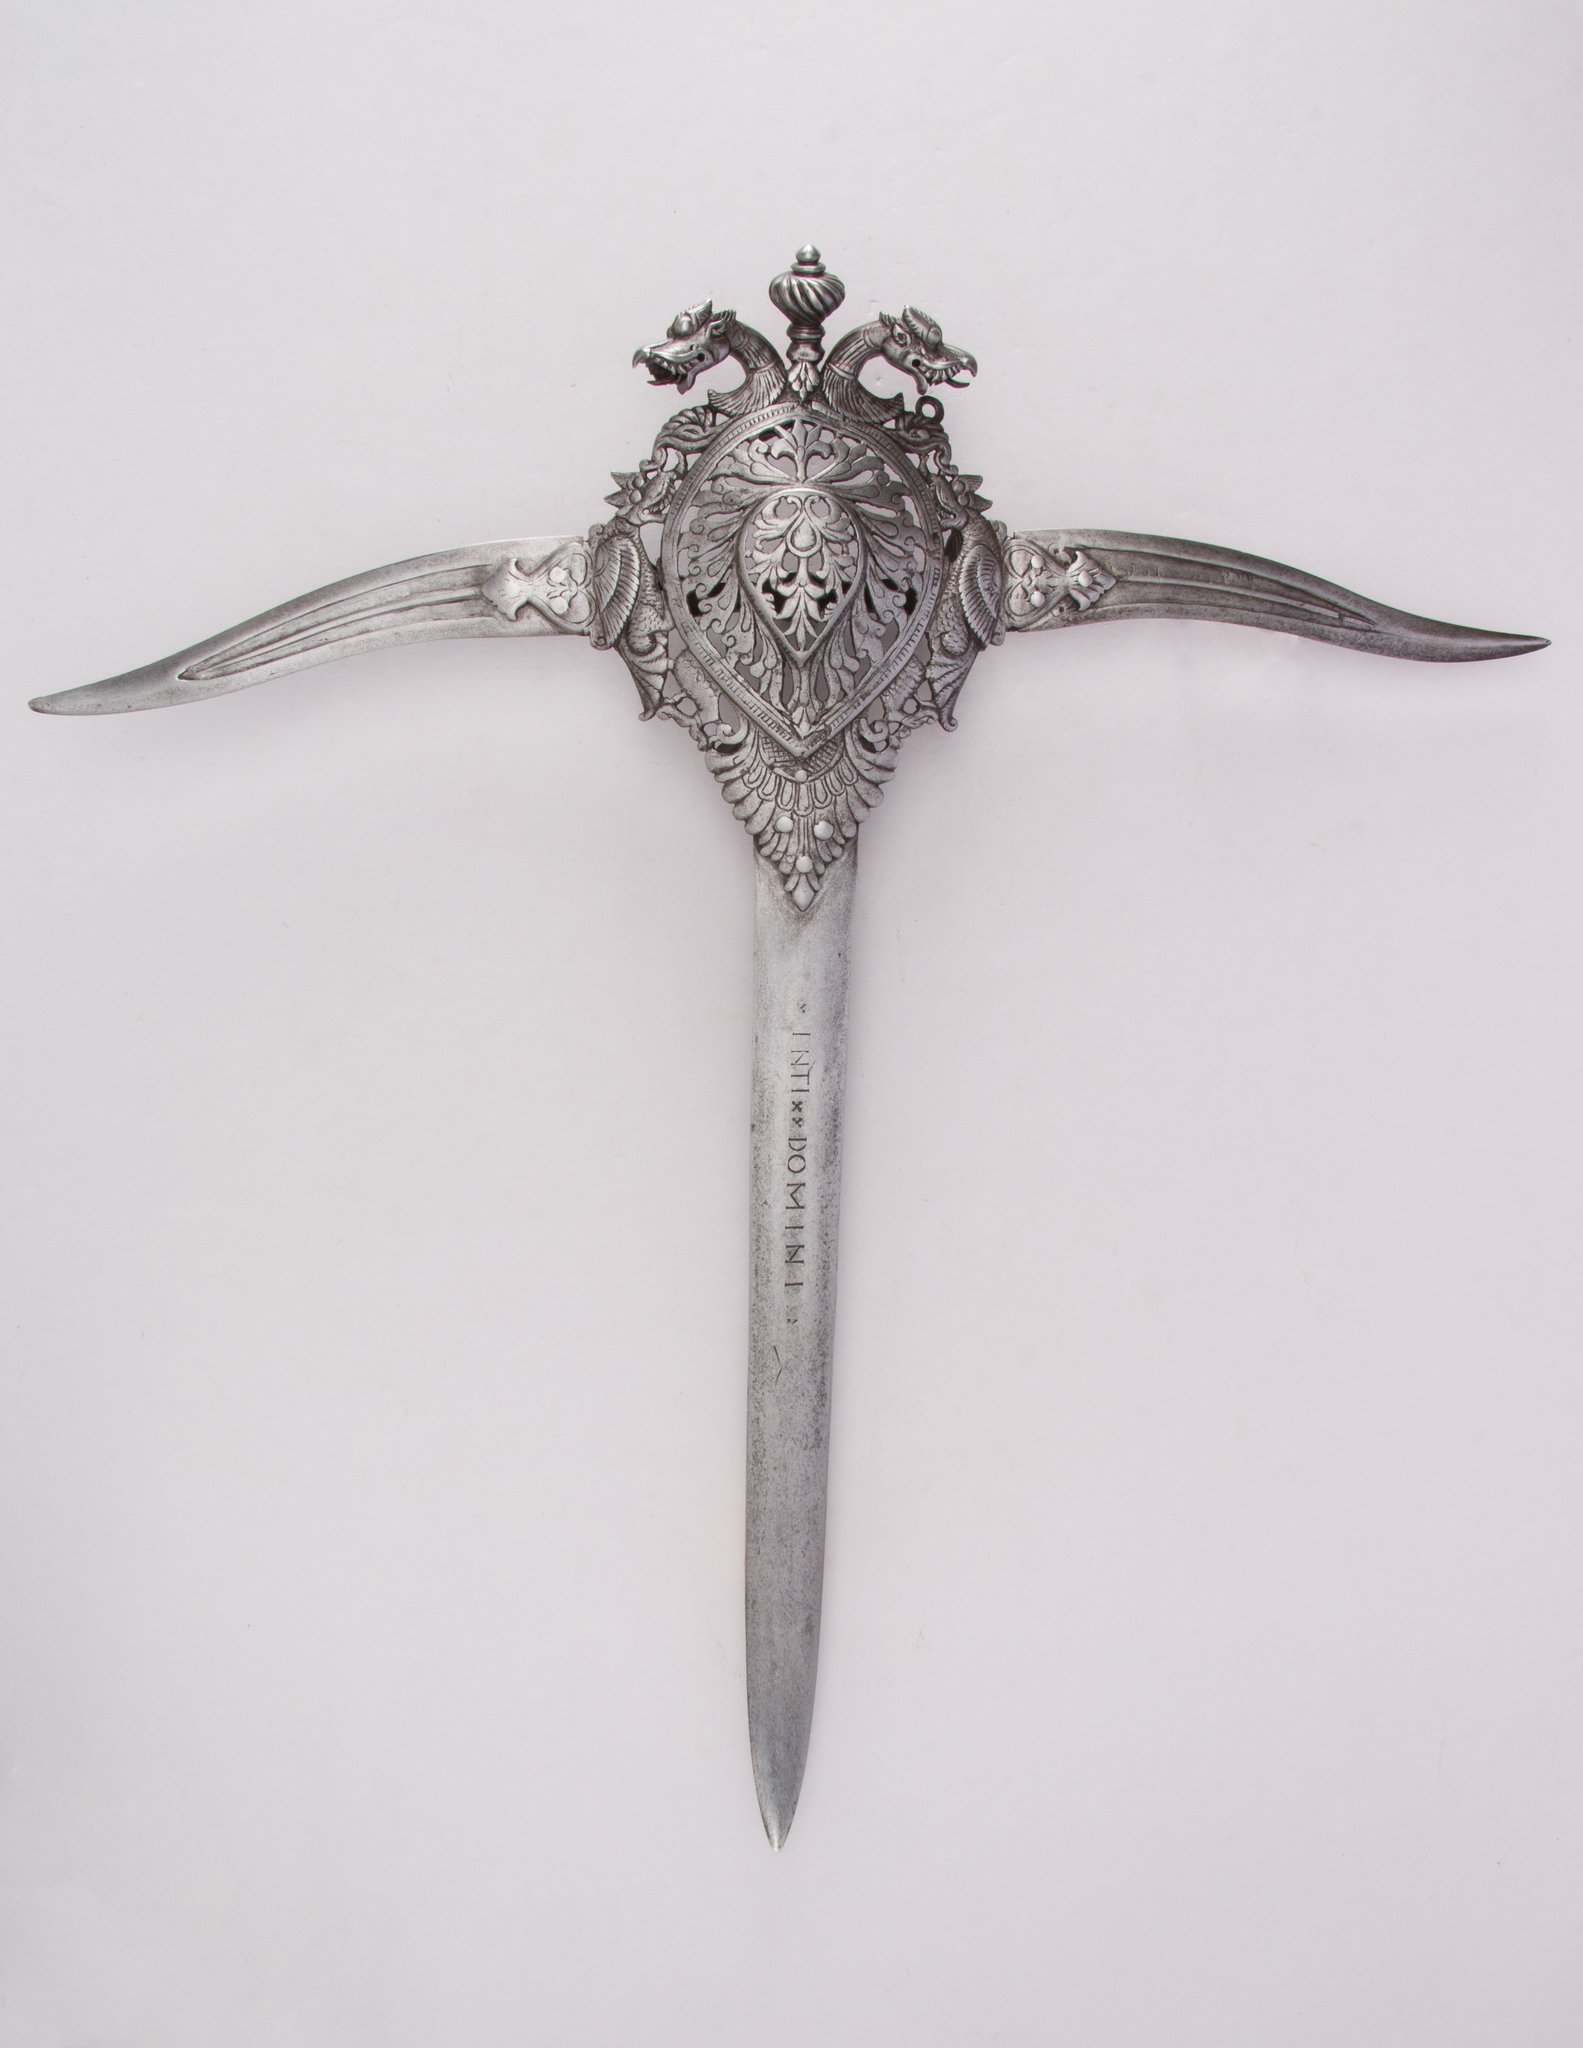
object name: dagger katar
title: Dagger (Katar)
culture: indian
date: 1601-1700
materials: steel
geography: germany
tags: dragons